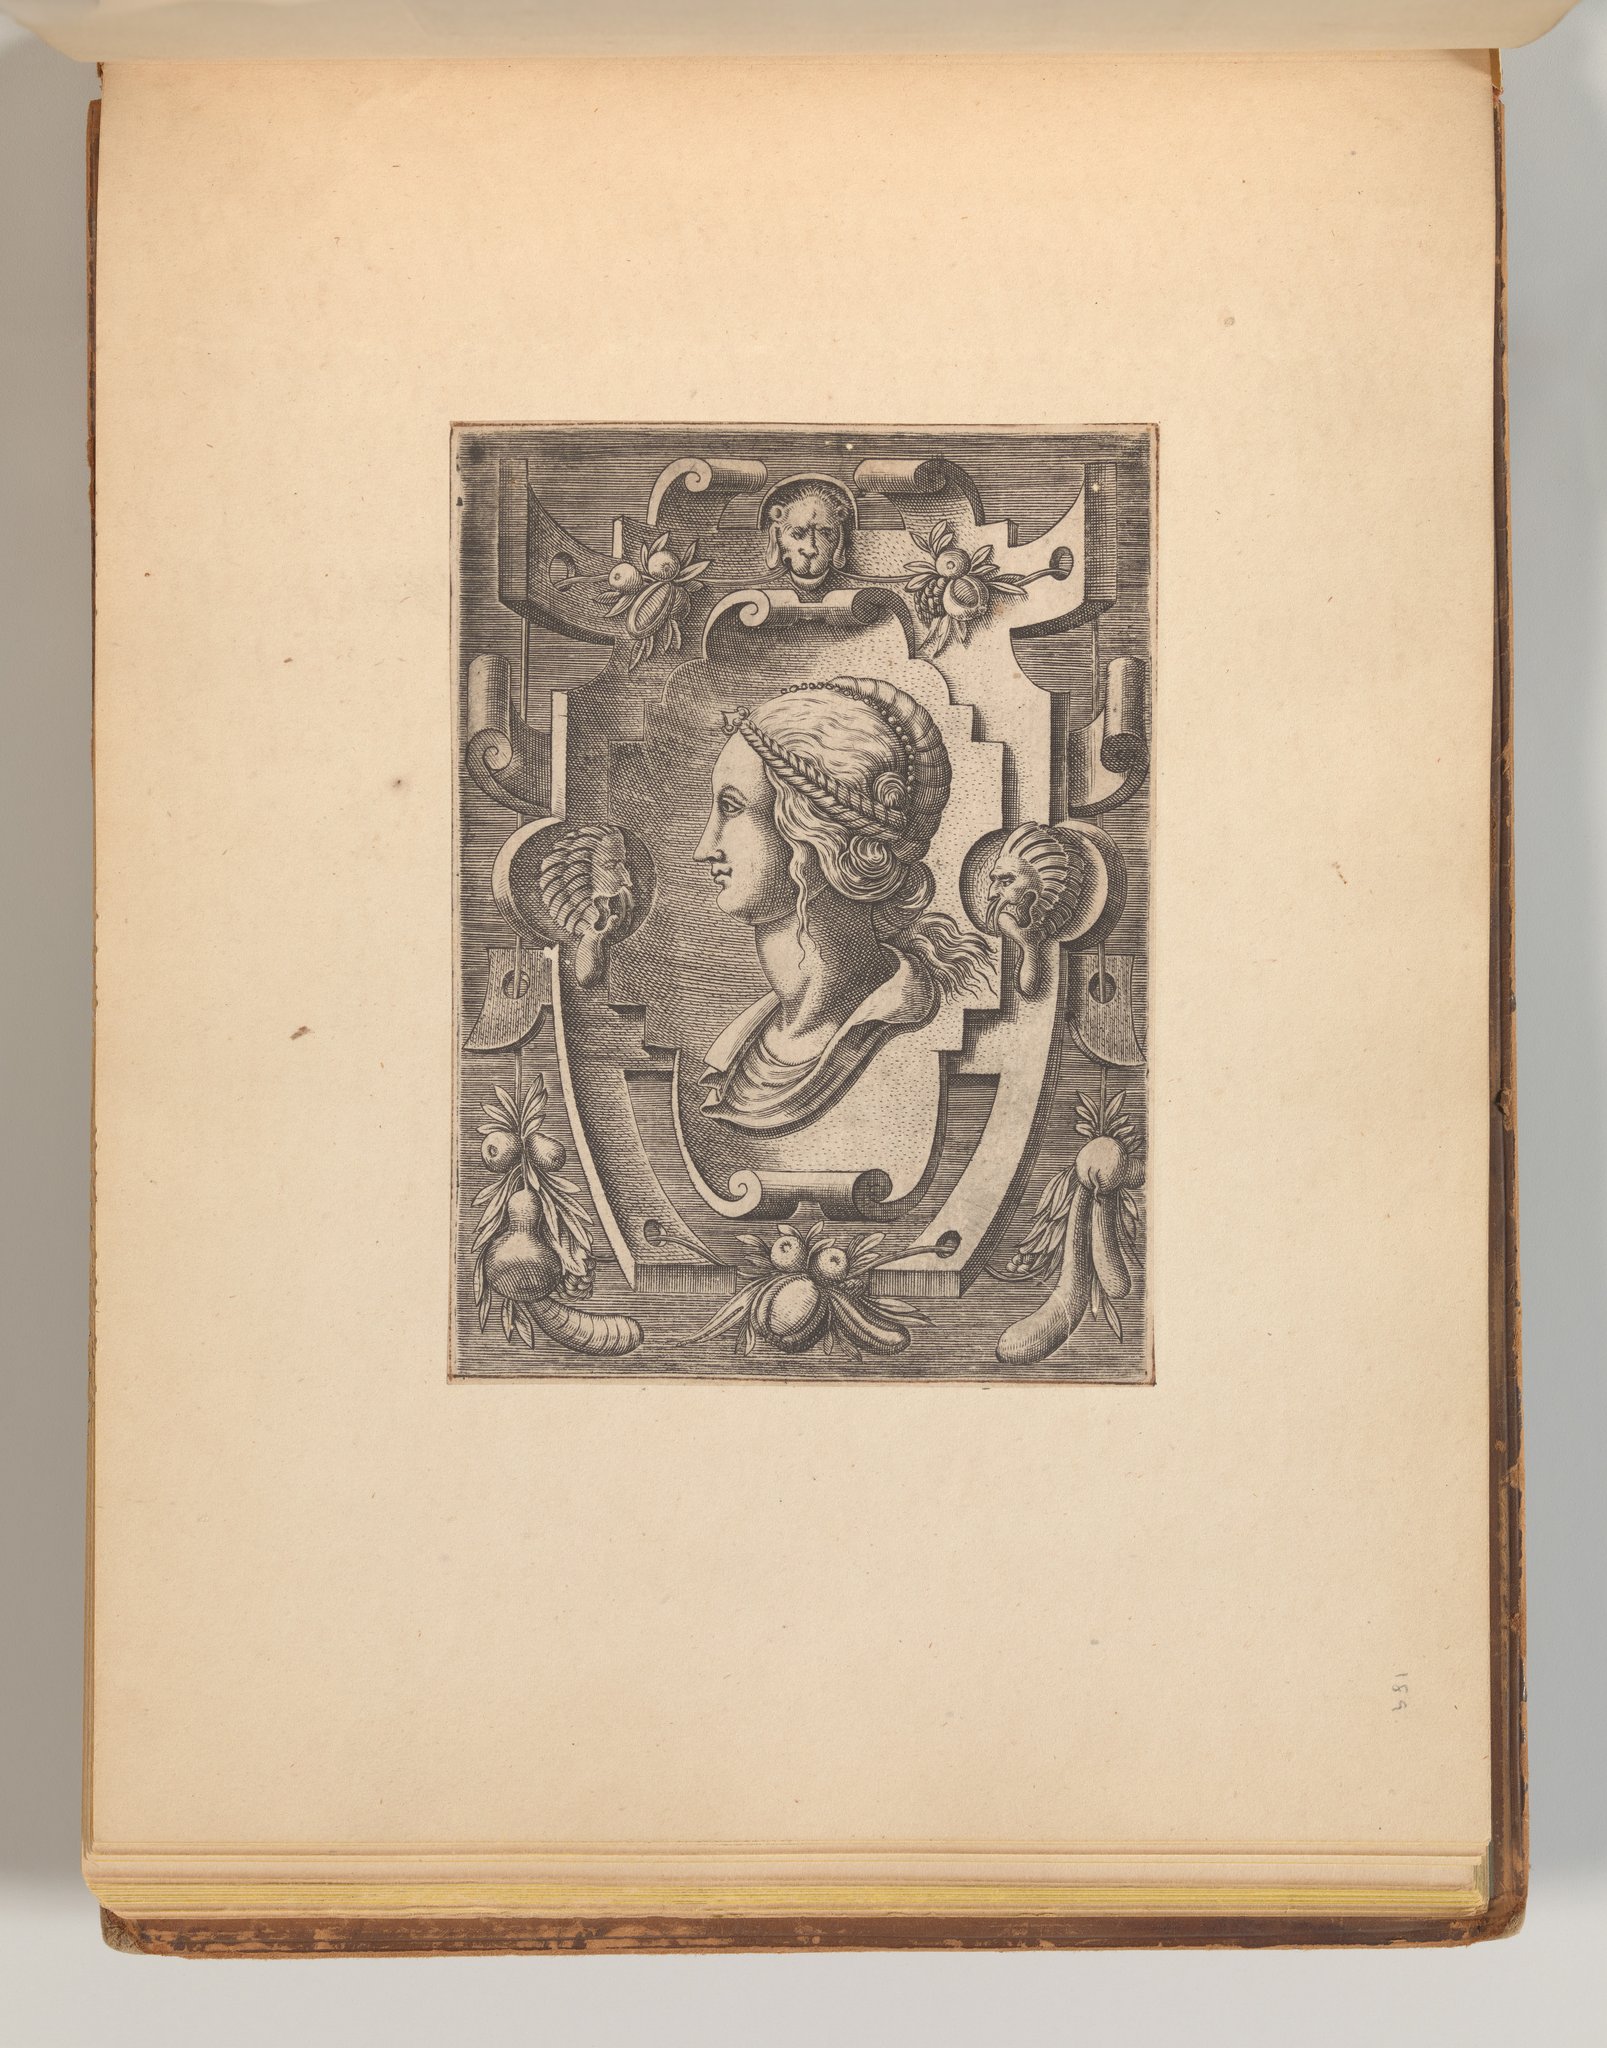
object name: album print ornament architecture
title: Series of Cartouches, in: Targhe ed altri ornati di varie e capricciose invenzioni (Cartouches and other ornaments of various and capricious invention, page 37)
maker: cornelis bos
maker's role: artist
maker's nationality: netherlandish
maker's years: 1510-1556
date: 1545-1560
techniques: engraving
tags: cartouches,profiles,women